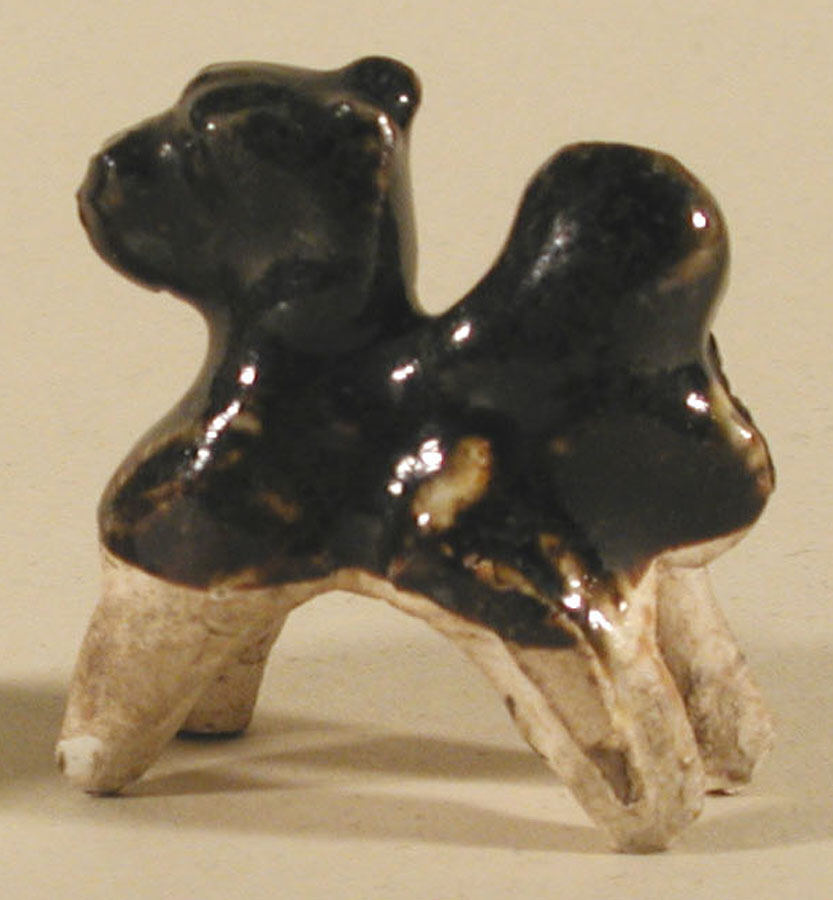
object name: figure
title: Dog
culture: chinese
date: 601-900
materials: earthenware, glaze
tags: dogs